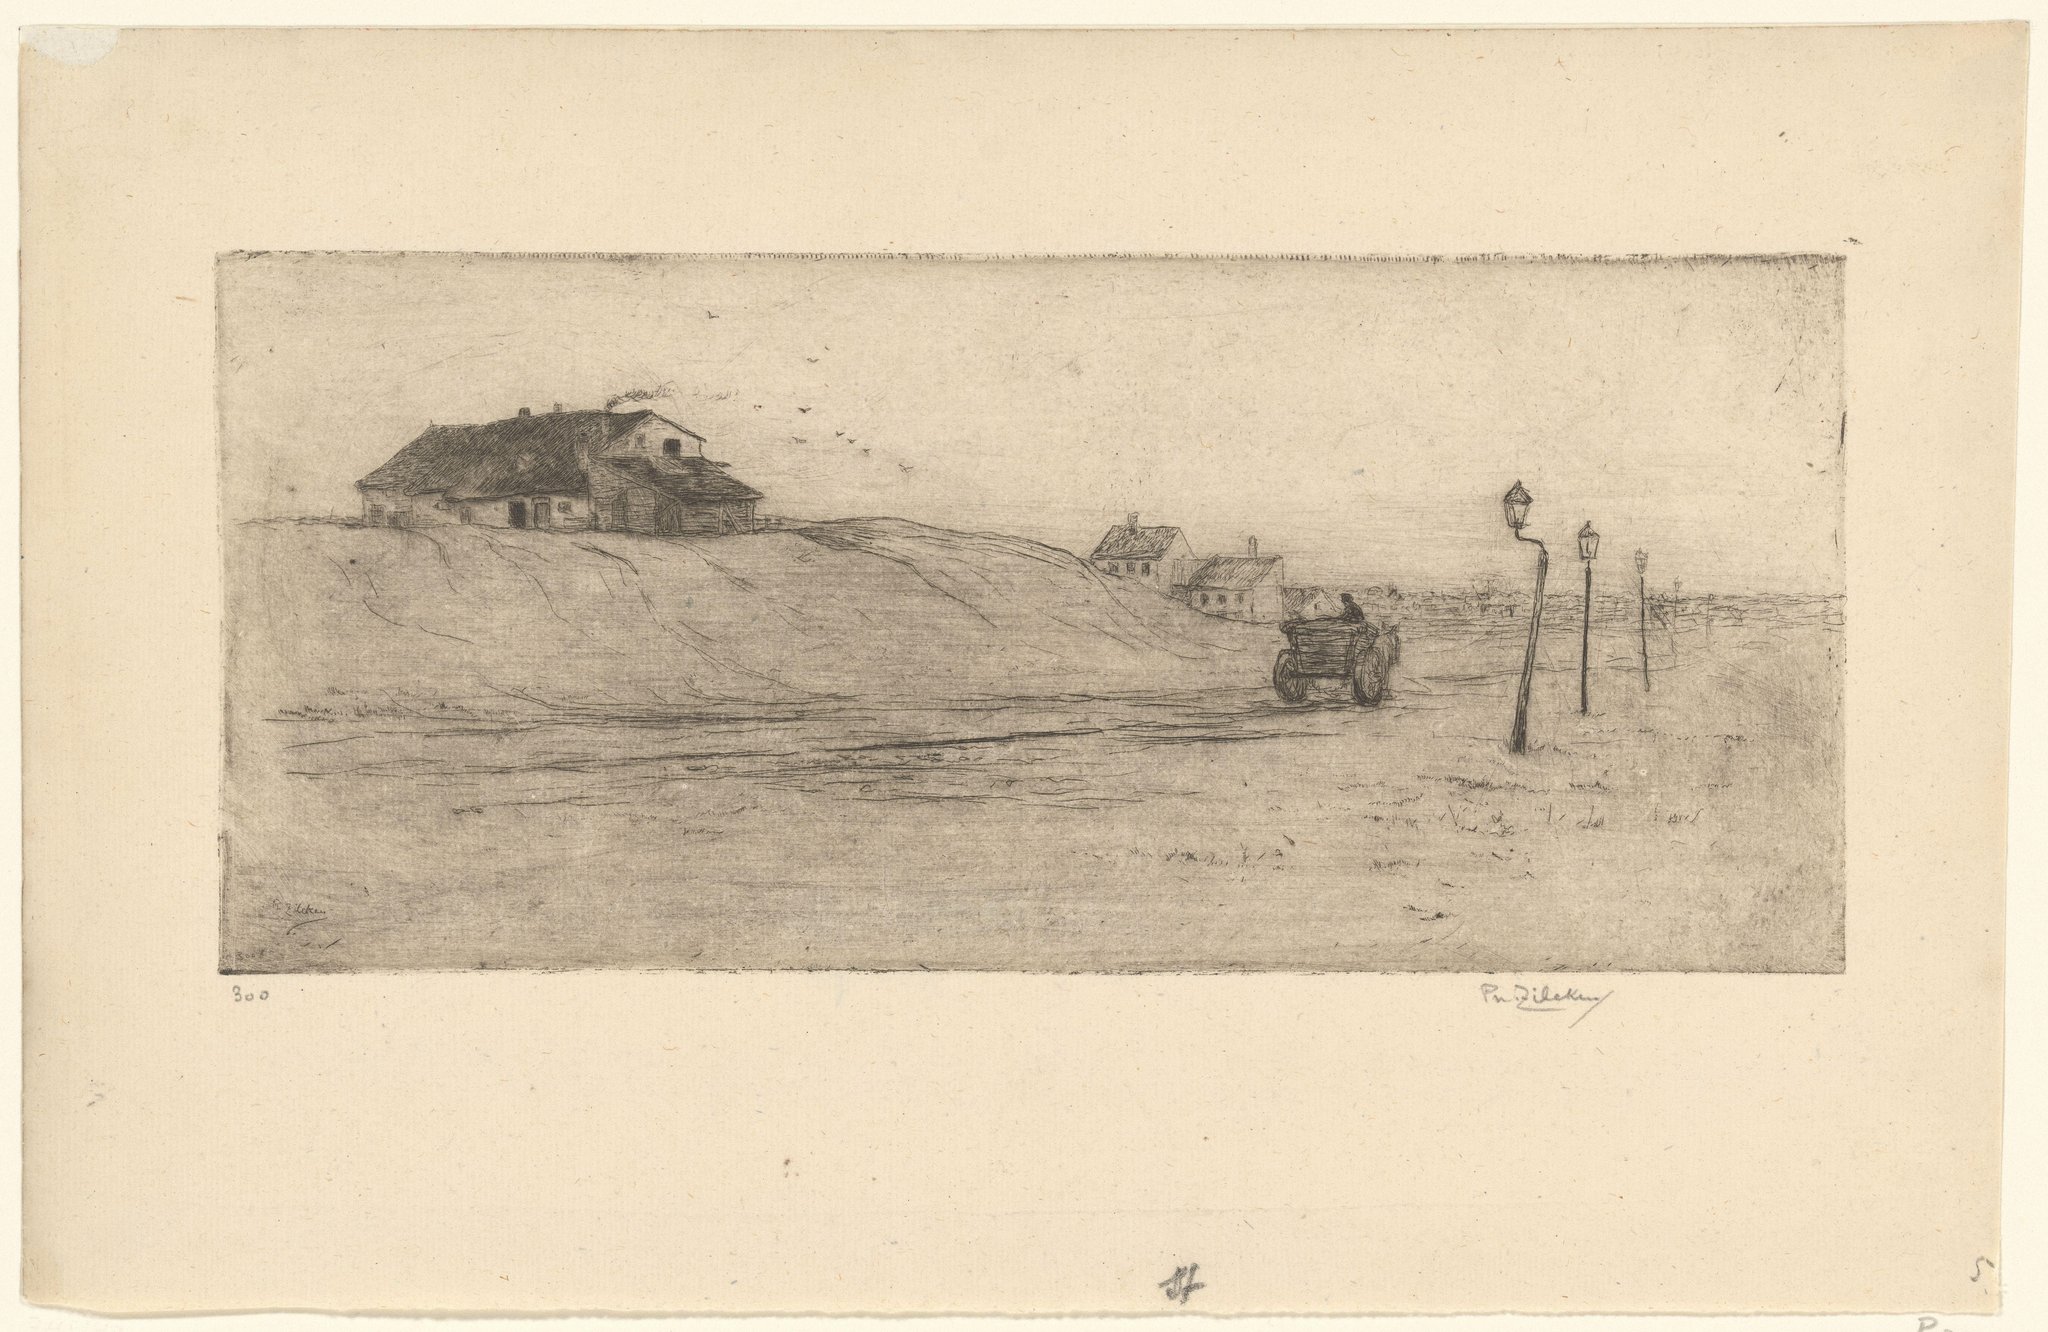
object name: print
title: Landschap met huizen, lantaarns en wagen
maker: philip zilcken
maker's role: draughtsman, painter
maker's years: 1857-1930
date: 1890-1930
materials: paper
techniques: drypoint, etching, intaglio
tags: road, path, lantern, (farm) wagon, freight wagon, cart, brussels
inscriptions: collector's mark: Lugt 2228, collector's mark: Lugt 2760